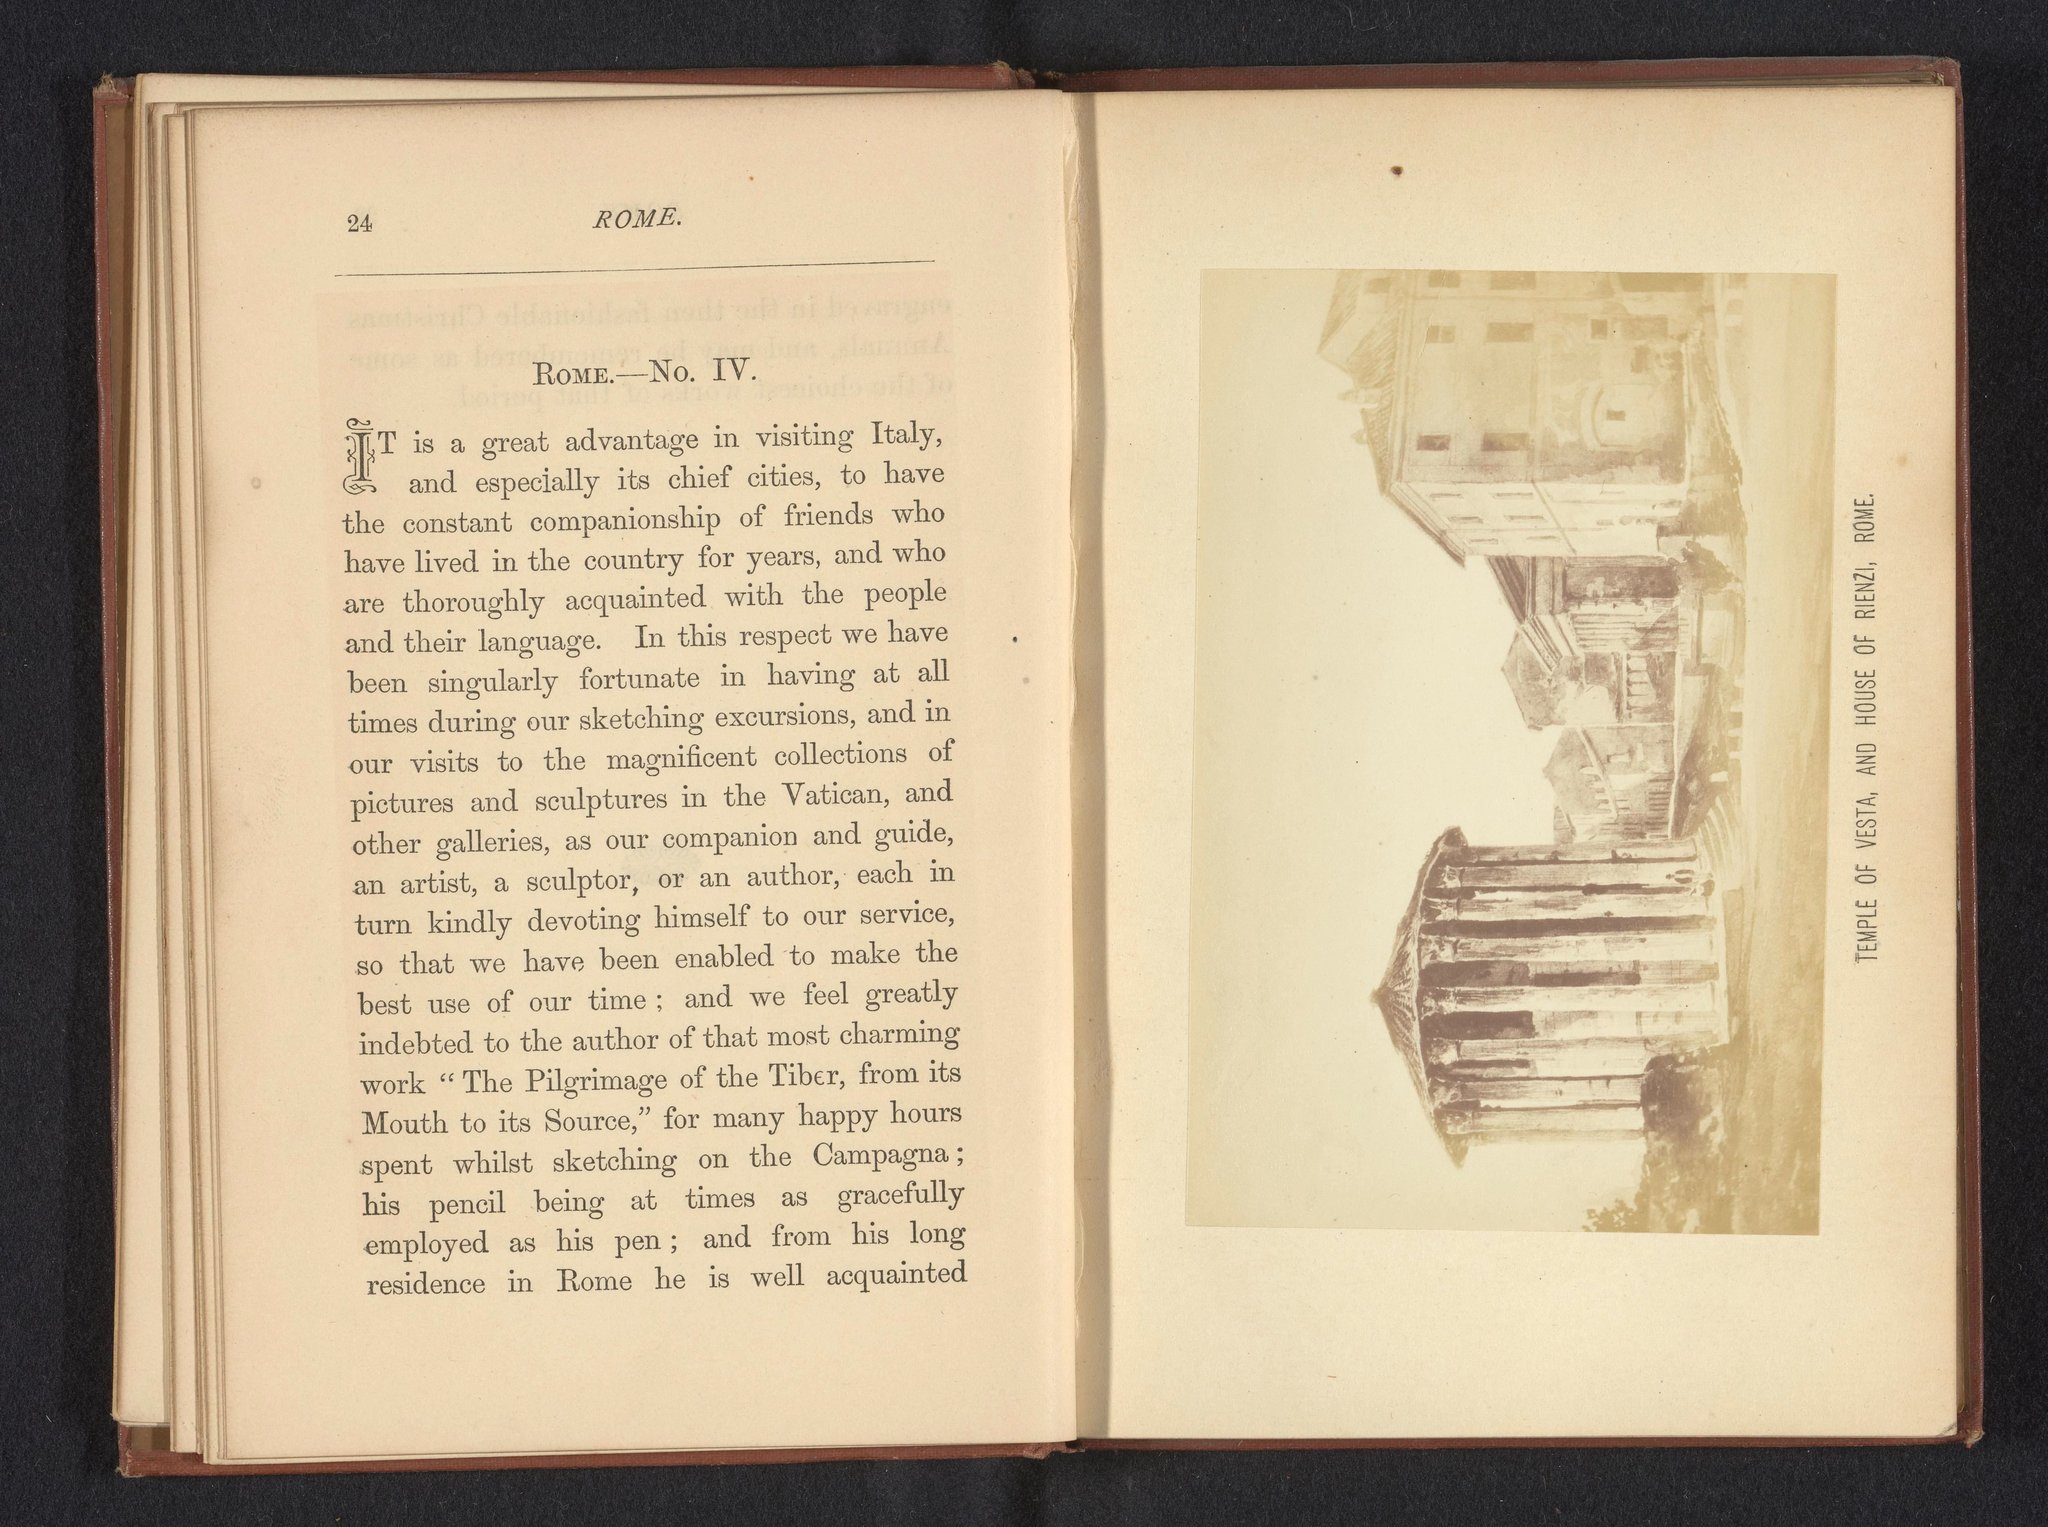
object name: photograph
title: Temple of Vesta, and house of Rienzi, Rome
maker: j. greer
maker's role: fotograaf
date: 1867-1877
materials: photographic support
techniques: albumen print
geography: forum romanum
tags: temple, shrine ~ roman religion